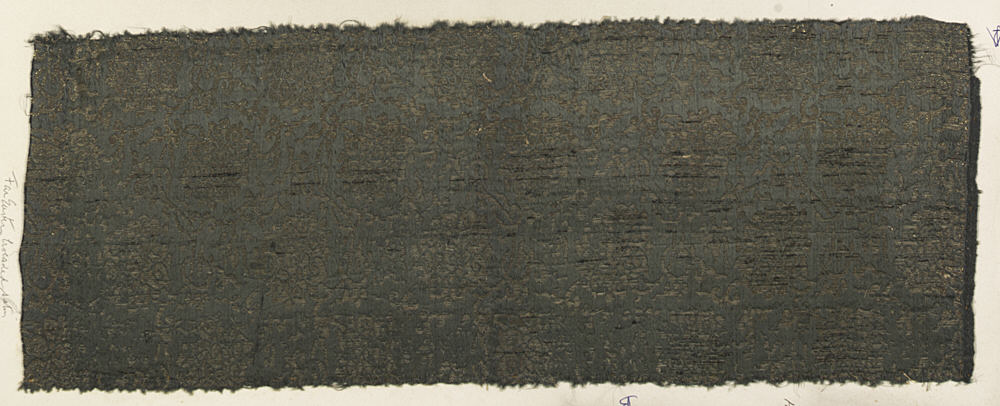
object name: piece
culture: china or japan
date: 1601-1900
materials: metal thread, silk